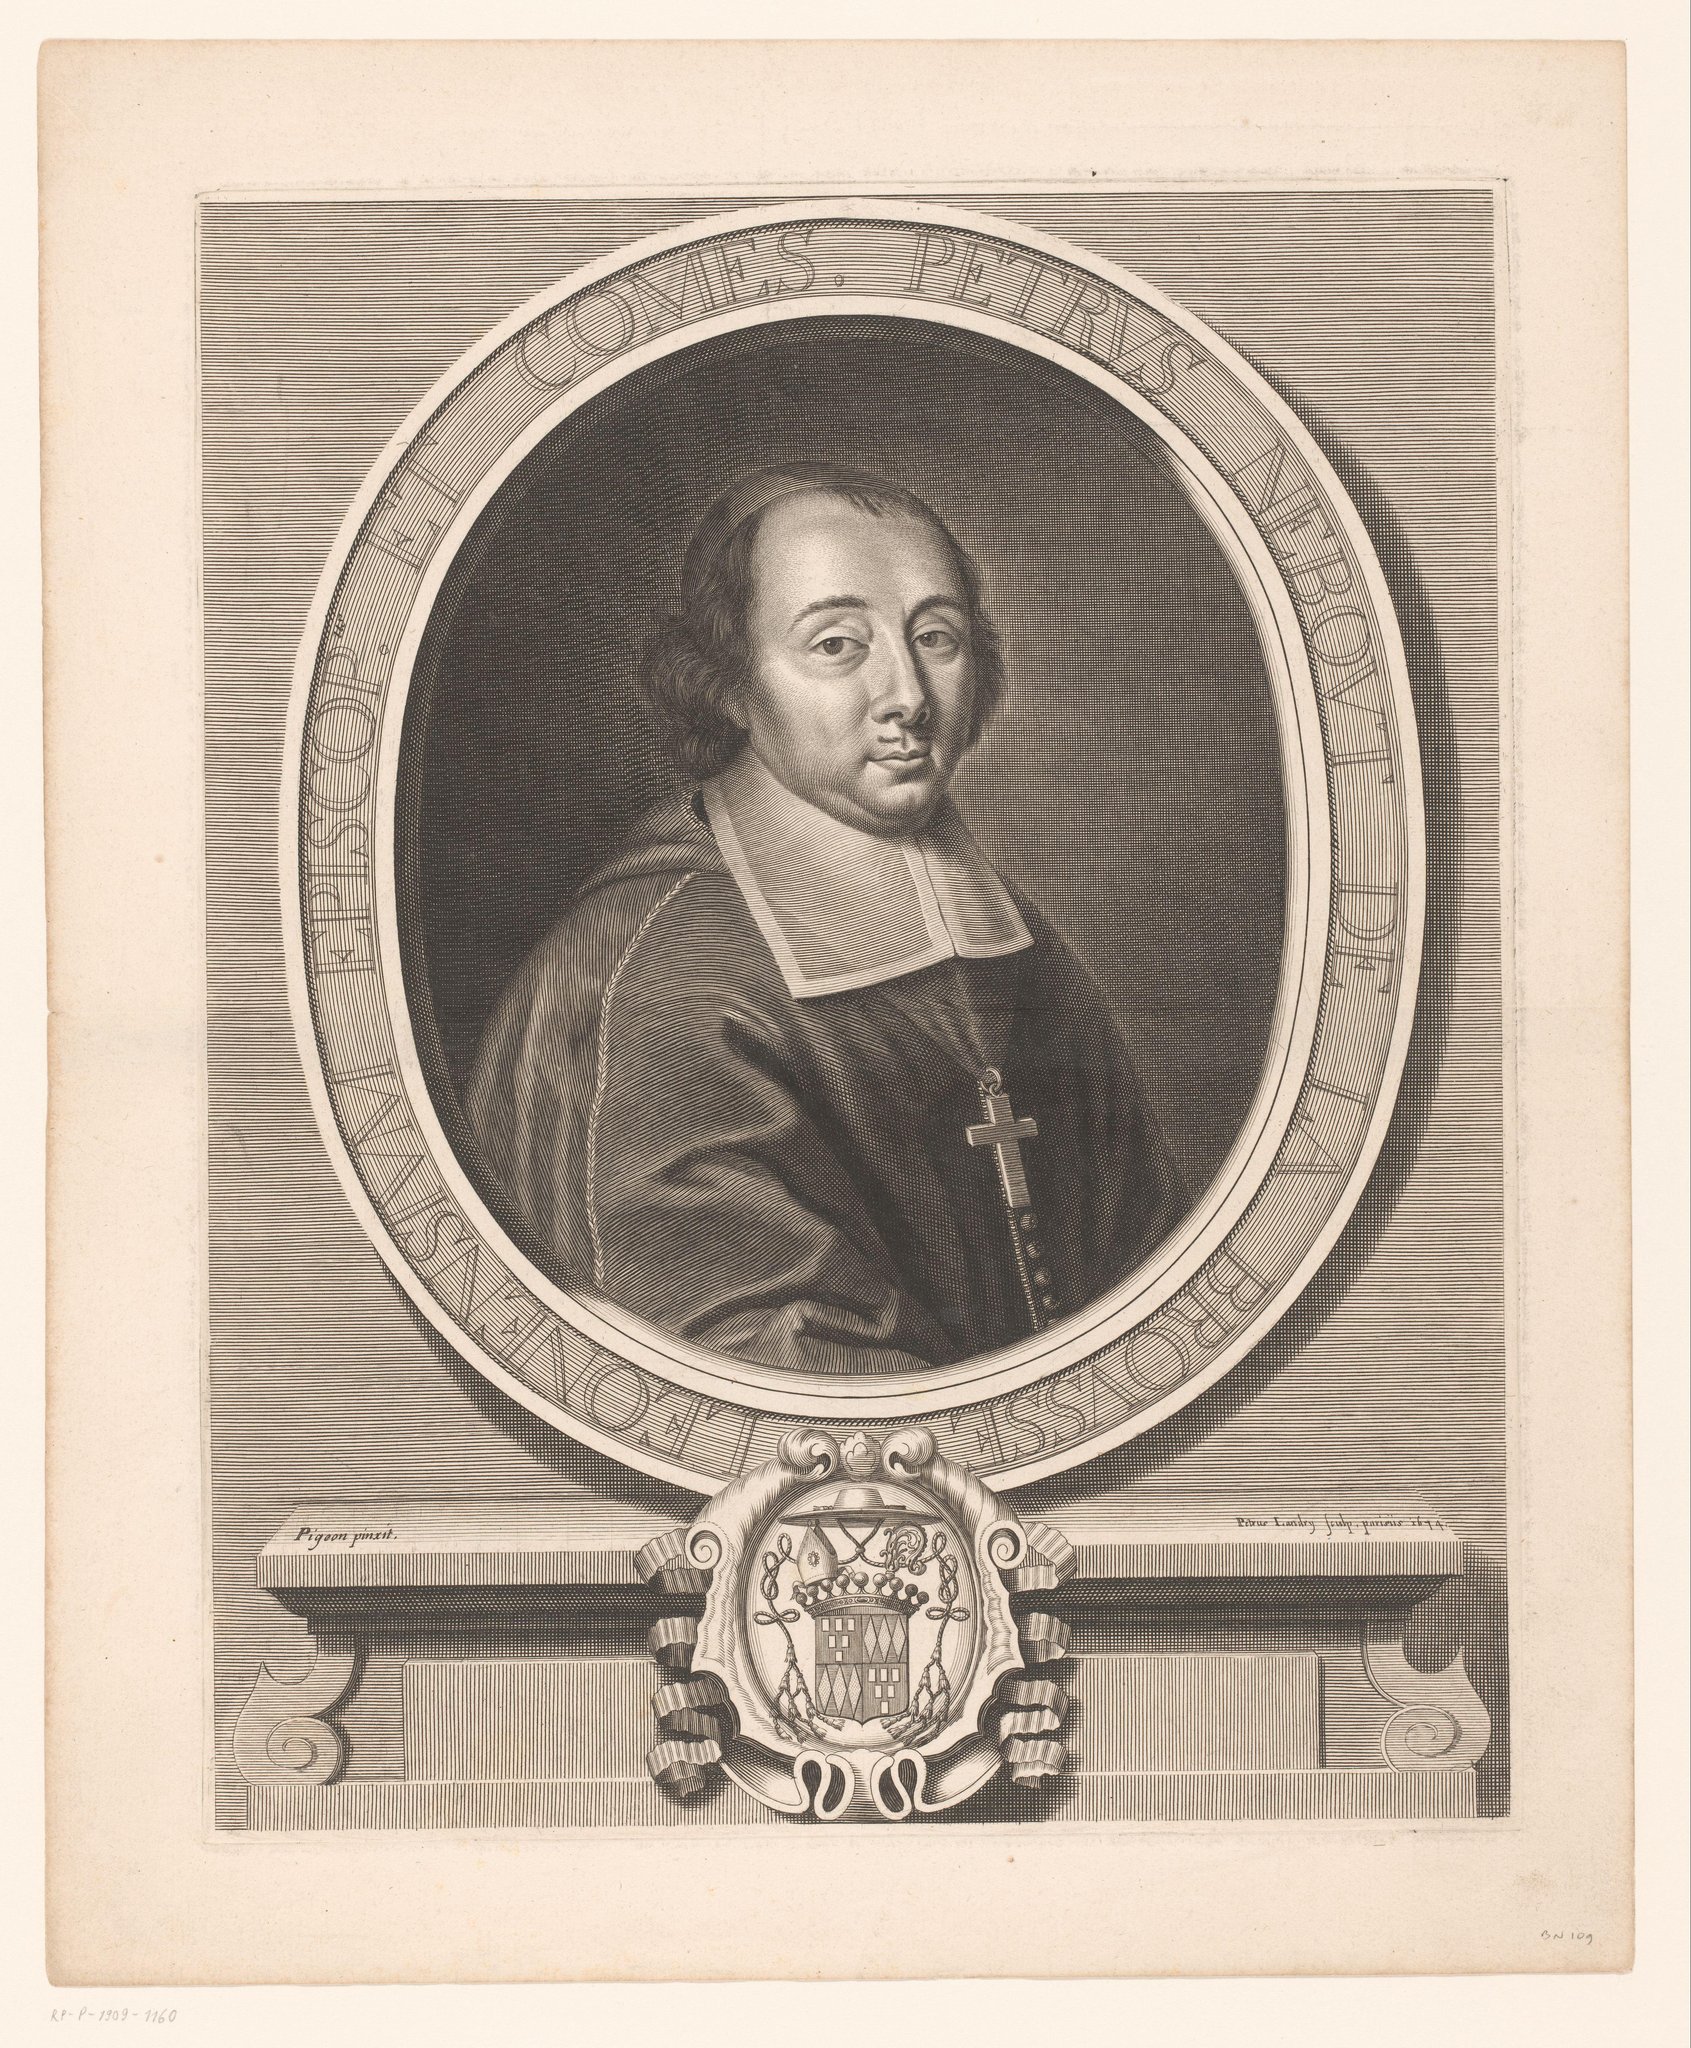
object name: print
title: Portret van Pierre Nebout de la Brousse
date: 1614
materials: paper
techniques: engraving, etching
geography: paris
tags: clergyman, archbishop, bishop, etc. (roman catholic), historical persons, armorial bearing, heraldry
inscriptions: collector's mark: Lugt 2228